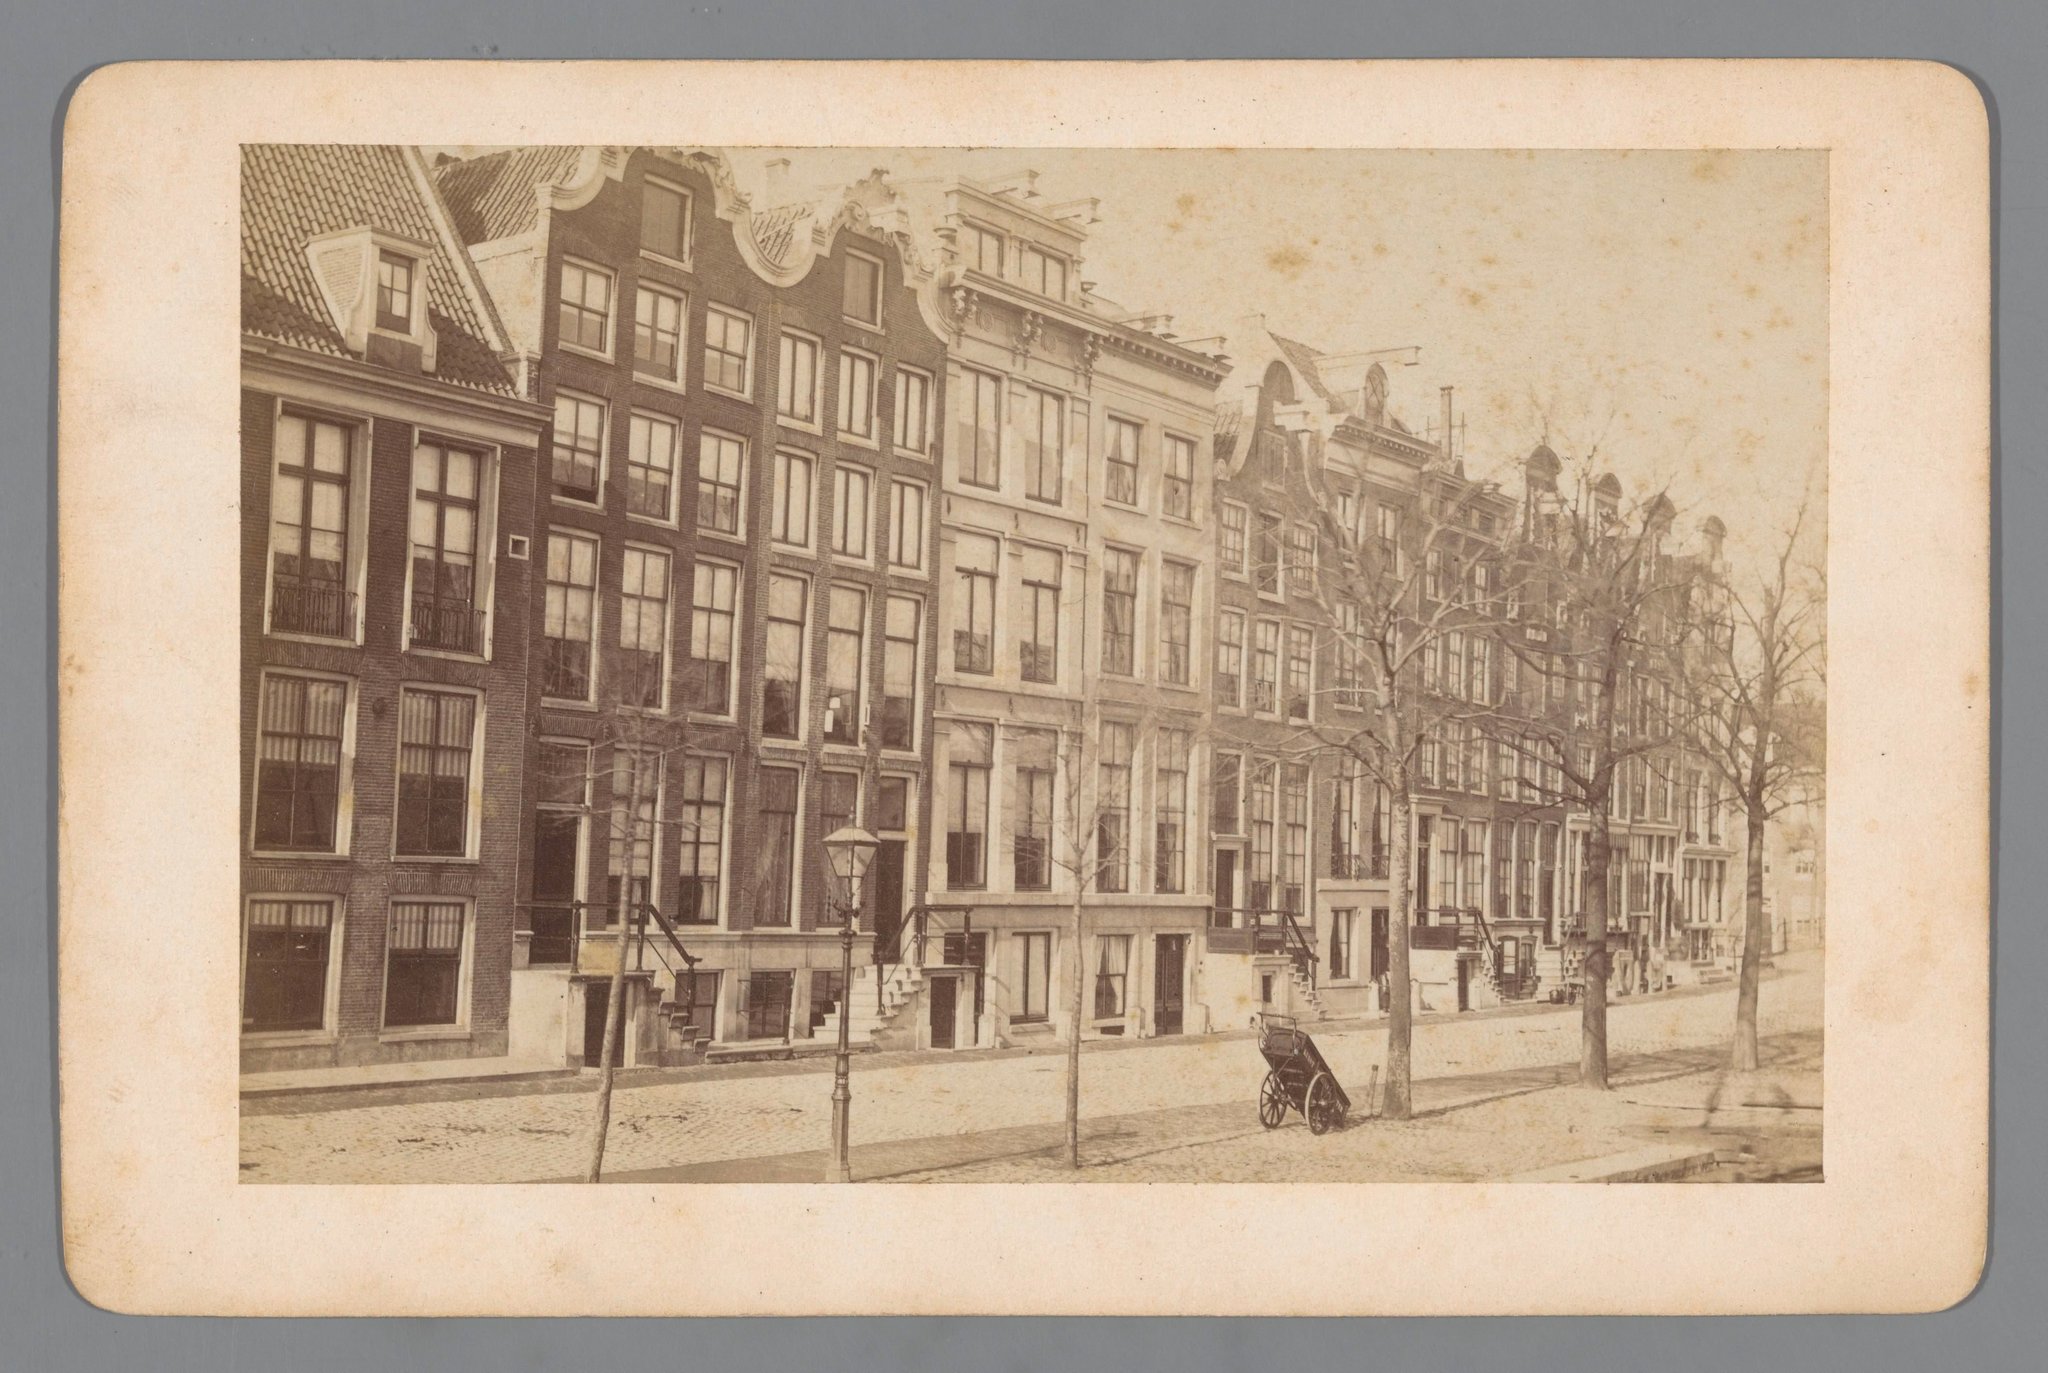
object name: cabinet photograph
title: Gezicht op een rij huizen aan de Amstel in Amsterdam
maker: Anonymous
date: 1850-1900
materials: cardboard, photographic support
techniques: albumen print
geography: amsterdam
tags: the usual house or row of houses, street, amsterdam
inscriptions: annotation: ‘Binnen Amstel’